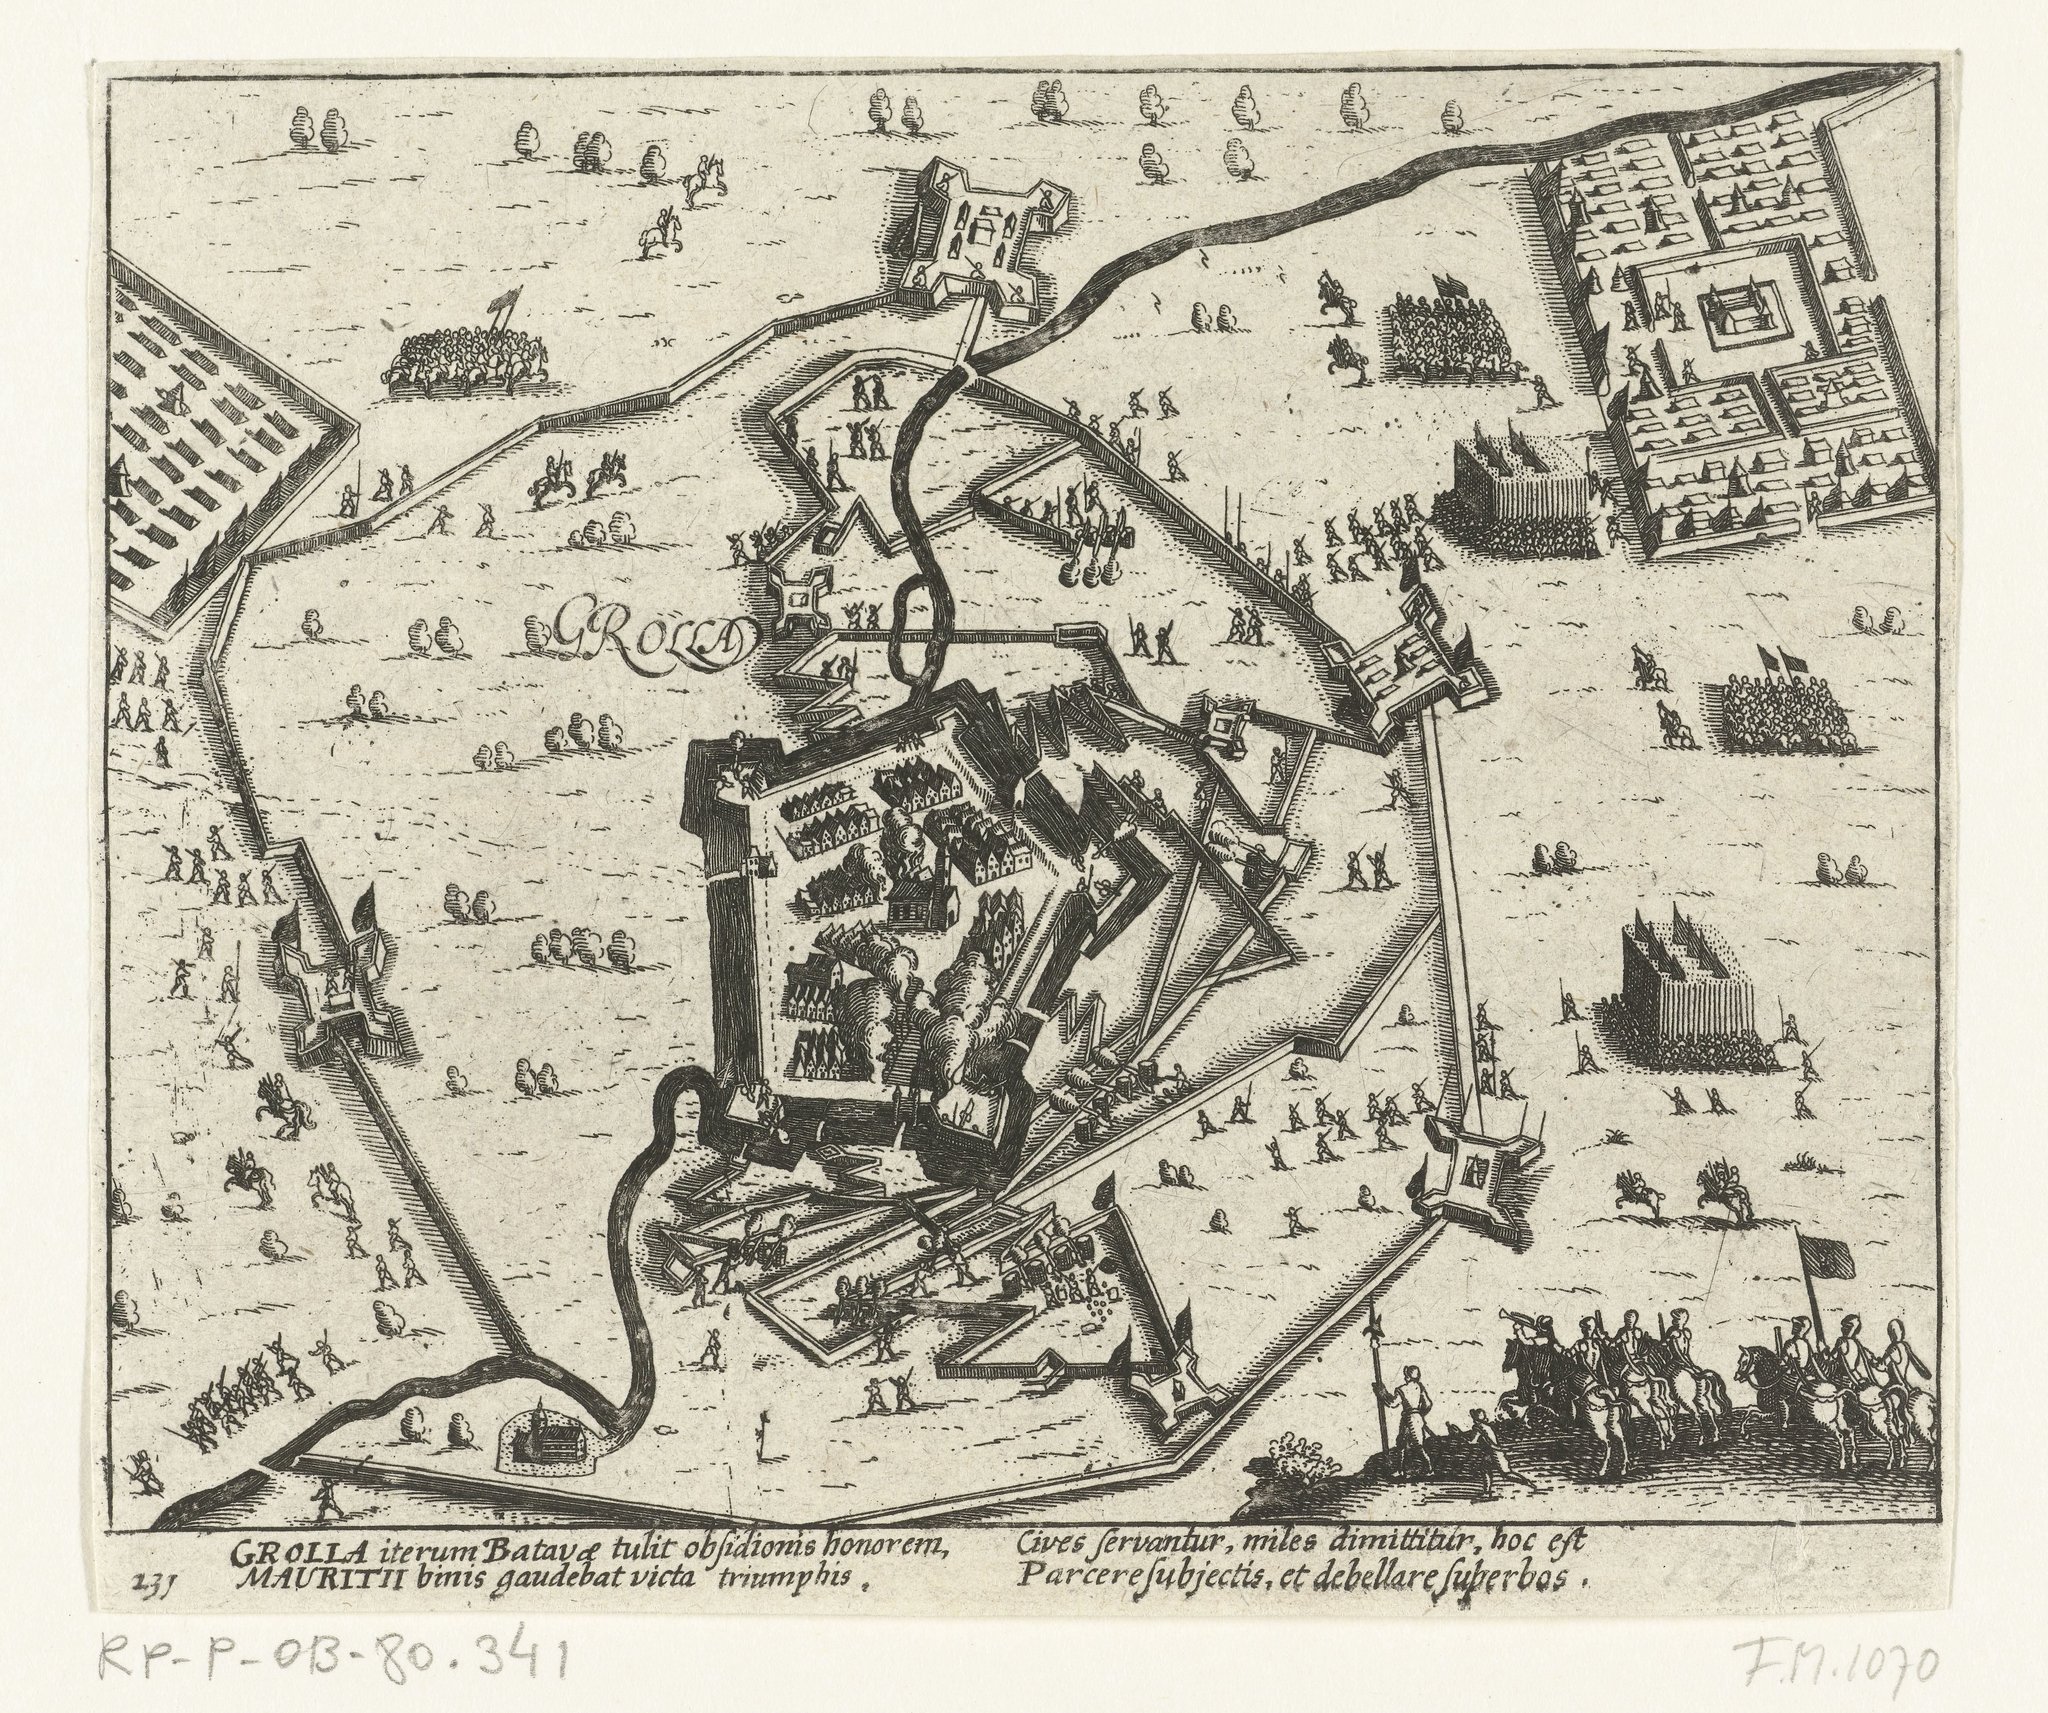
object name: history print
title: Beleg en verovering van Groenlo, 1597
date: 1613-1615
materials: paper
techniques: etching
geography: northern netherlands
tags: maurice (prince of orange), siege, position war, capture of city (after the siege)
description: Beleg en verovering van Groenlo (Grol) door het Staatse leger onder prins Maurits, 28 september 1597. Plan van de stad met de posities van het belgerende Staatse leger. Met onderschrift van vier regels in het Latijn. Genummerd 231. Bedrukt op de achterzijde met tekst in het Latijn.